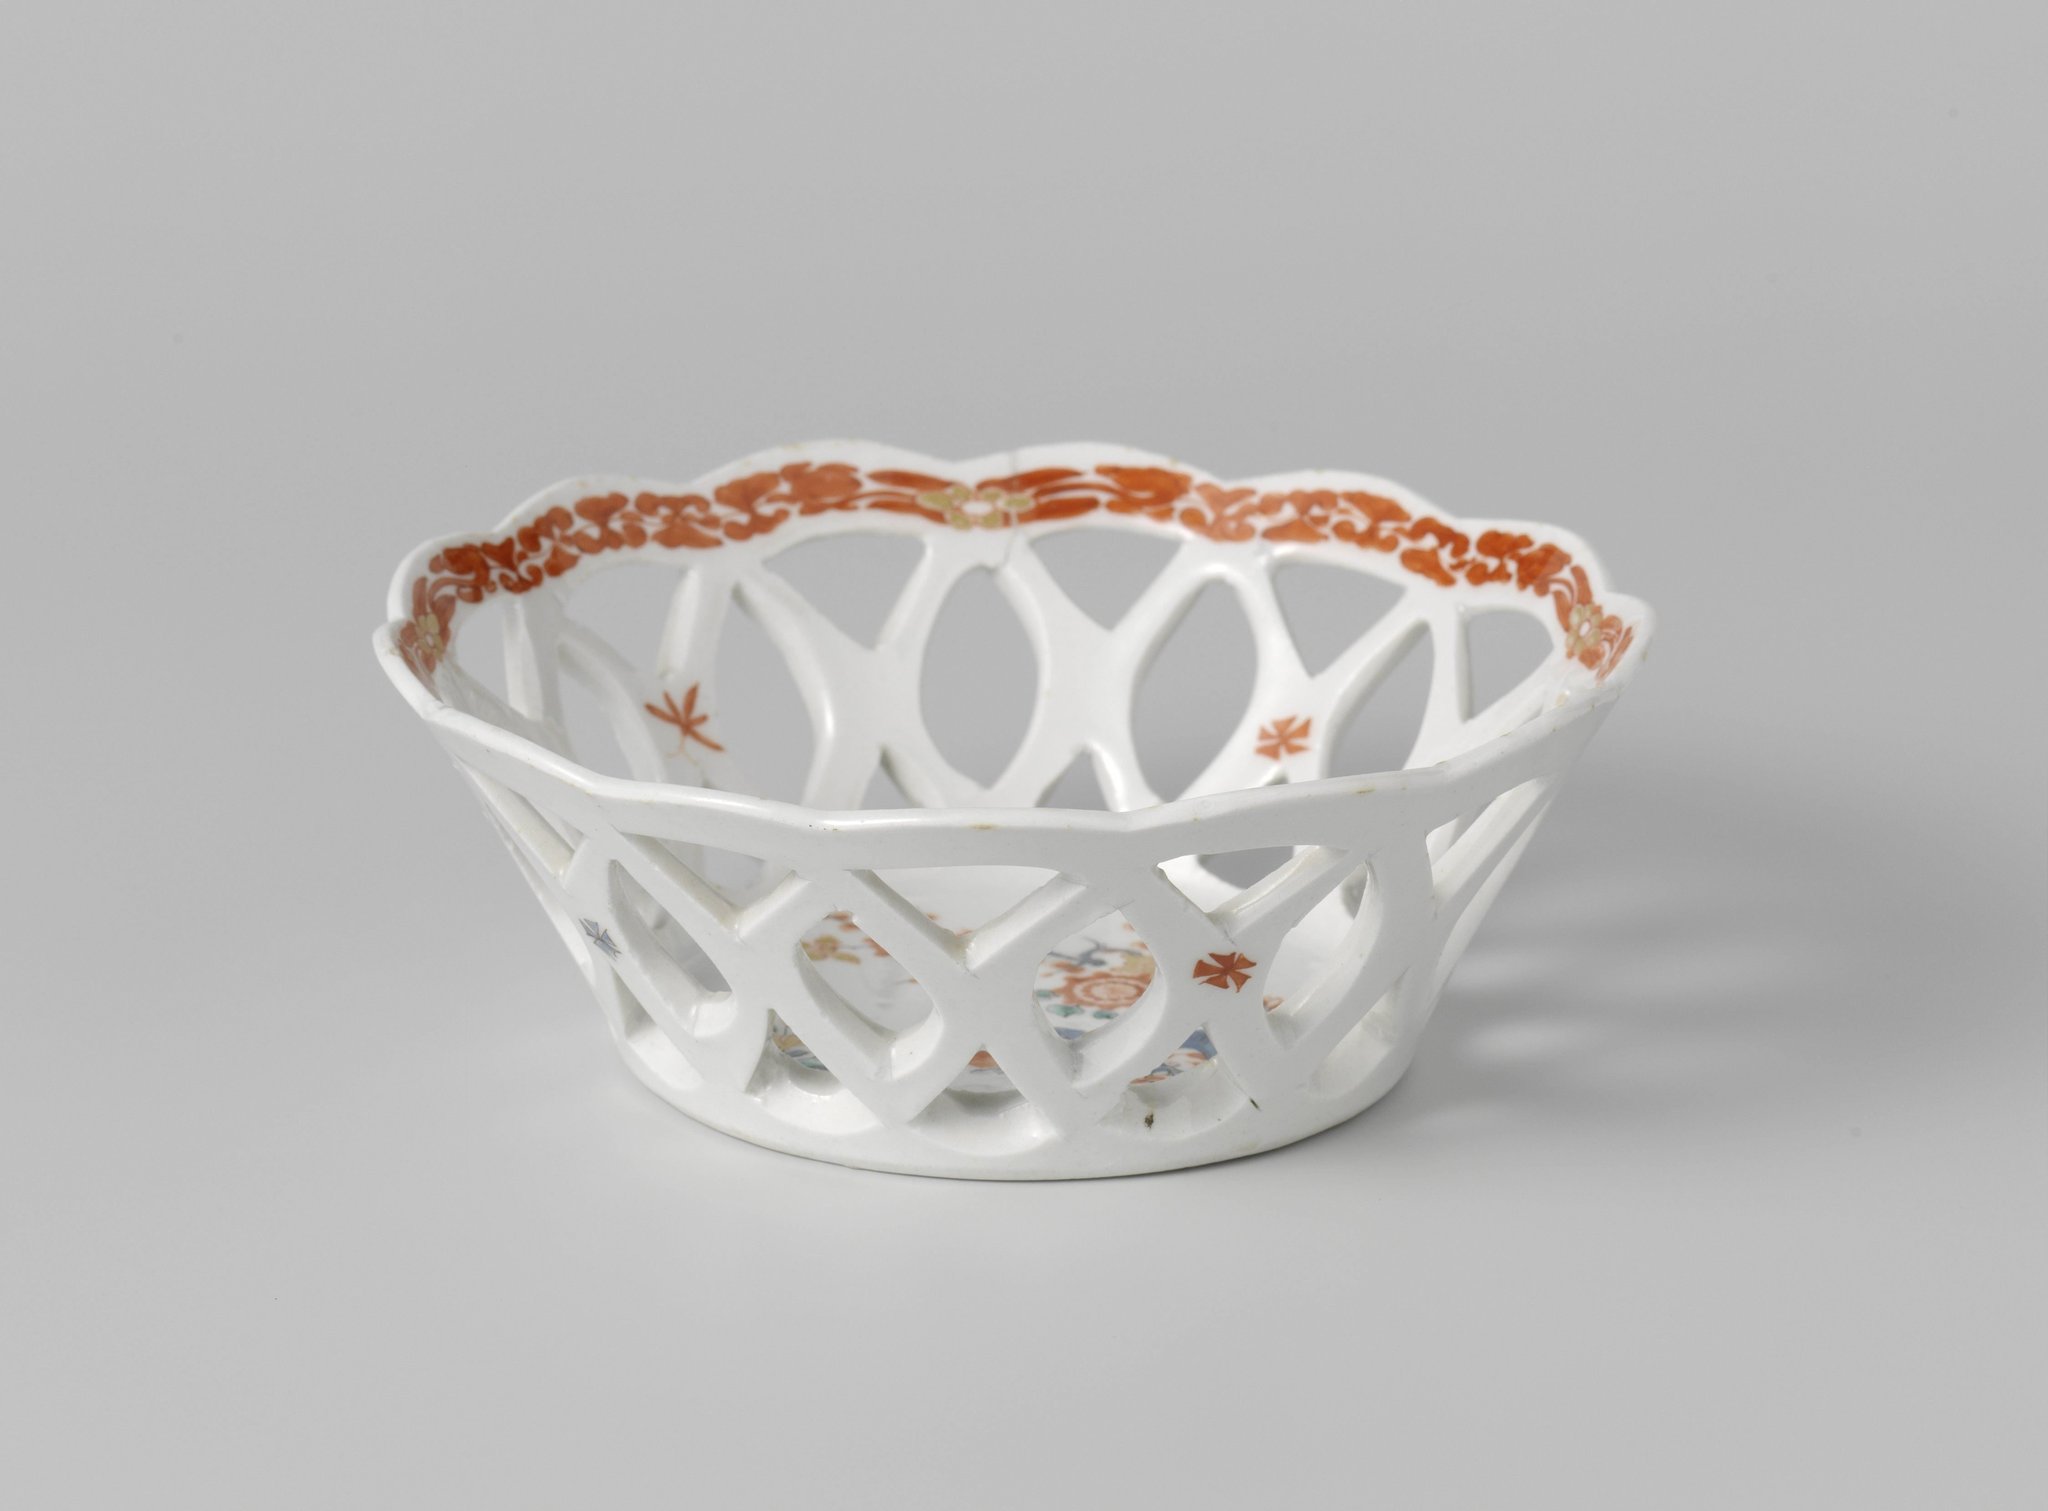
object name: bowl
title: Bowl with quails near flowering plants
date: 1750-1774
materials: glaze, gold, paint, porcelain, soft paste porcelain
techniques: embroidery, firing, forming, gilding, turning, vitrification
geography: worcester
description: Basket. Worcester, c. 1750 - 1775.